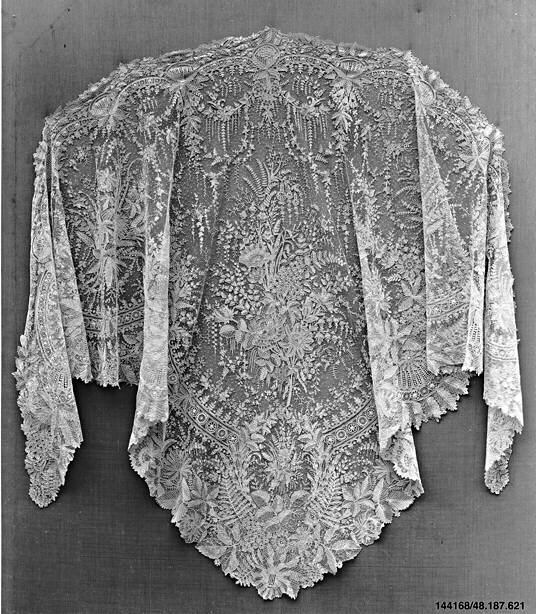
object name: shawl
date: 1851-1875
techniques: lace